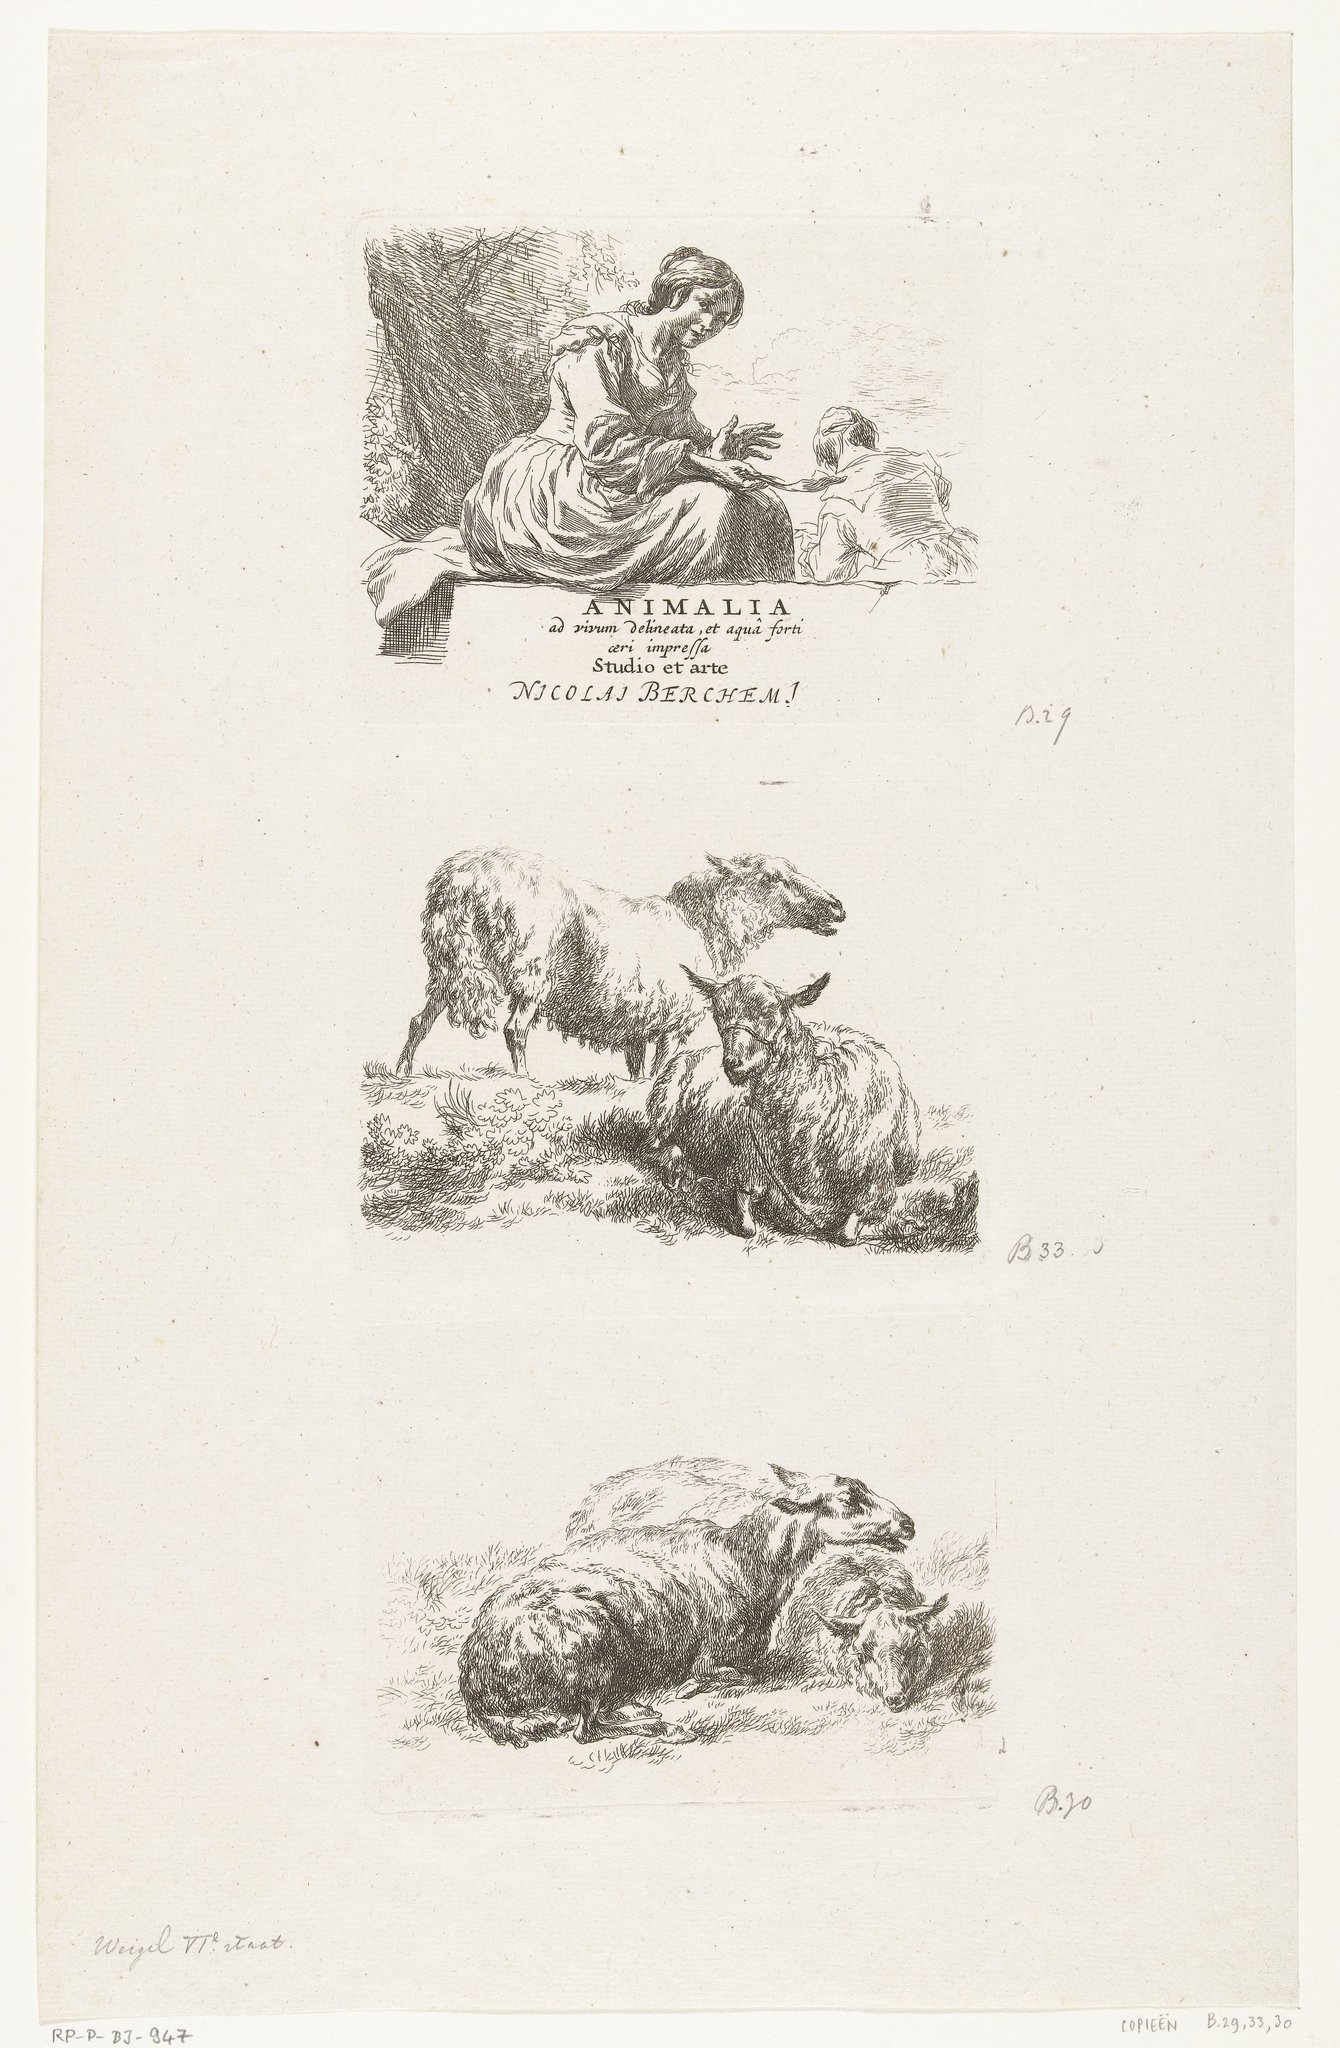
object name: print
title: Animalia ad vivum delineata et aqua forti aeri impressa Studio et Arte Nicolai Berchemi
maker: Anonymous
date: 1648-1733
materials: paper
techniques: etching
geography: netherlands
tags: sheep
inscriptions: collector's mark: Lugt 2228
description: Drie prenten uit een serie van zes prenten met schapen op een vel afgedrukt. Boven de titelprent met een jonge vrouw zittend op een steen, in het midden een liggend schaap met halster en een staand schaap en onder twee liggende schapen.